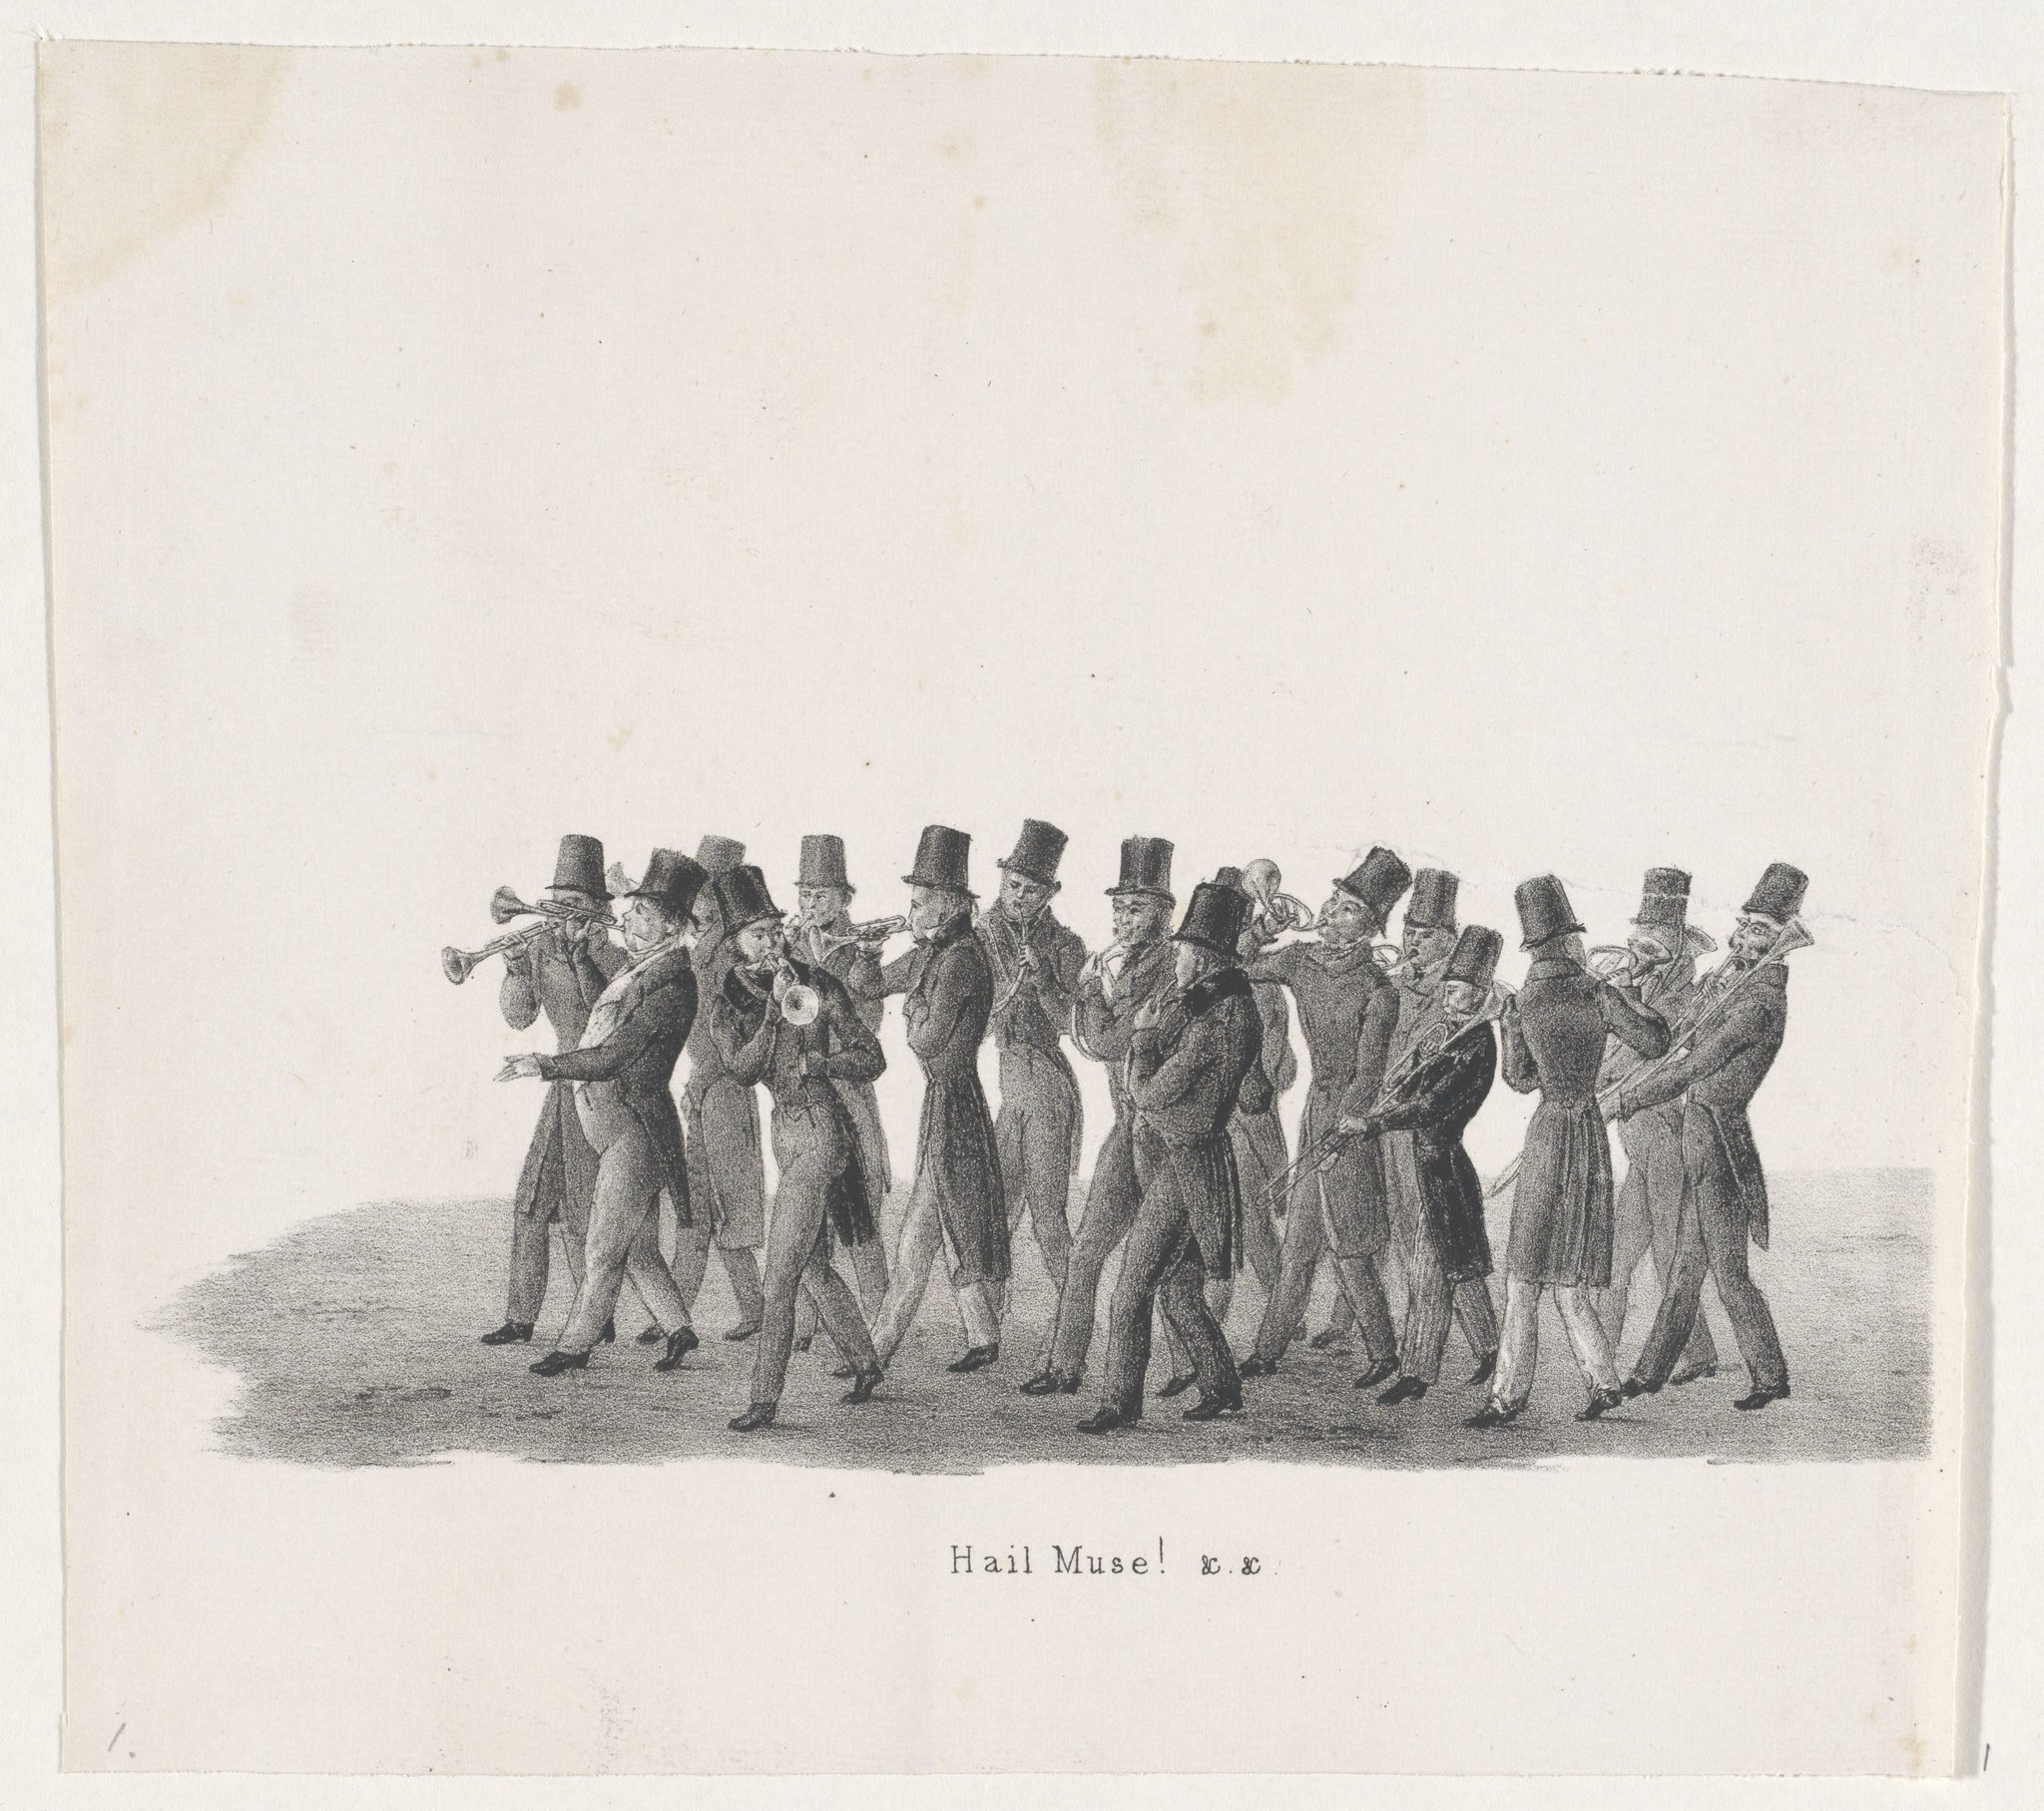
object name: print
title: De afzonderlijke voorstellingen, welke den optogt, gehouden door H.H. Studenten der Leidsche Hoogeschool op den 9 Feb: 1835, besloten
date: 1835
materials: paper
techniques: lithograph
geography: leiden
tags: students' pageant, commemoration of the founding of a university, leiden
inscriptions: collector's mark: Lugt 2228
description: Zestien muzikanten met blaasinstrumenten. Eerste groep in de optocht gehouden door studenten van de Leidse Hogeschool ter viering van de dies natalis van de universiteit op 9 februari 1835.